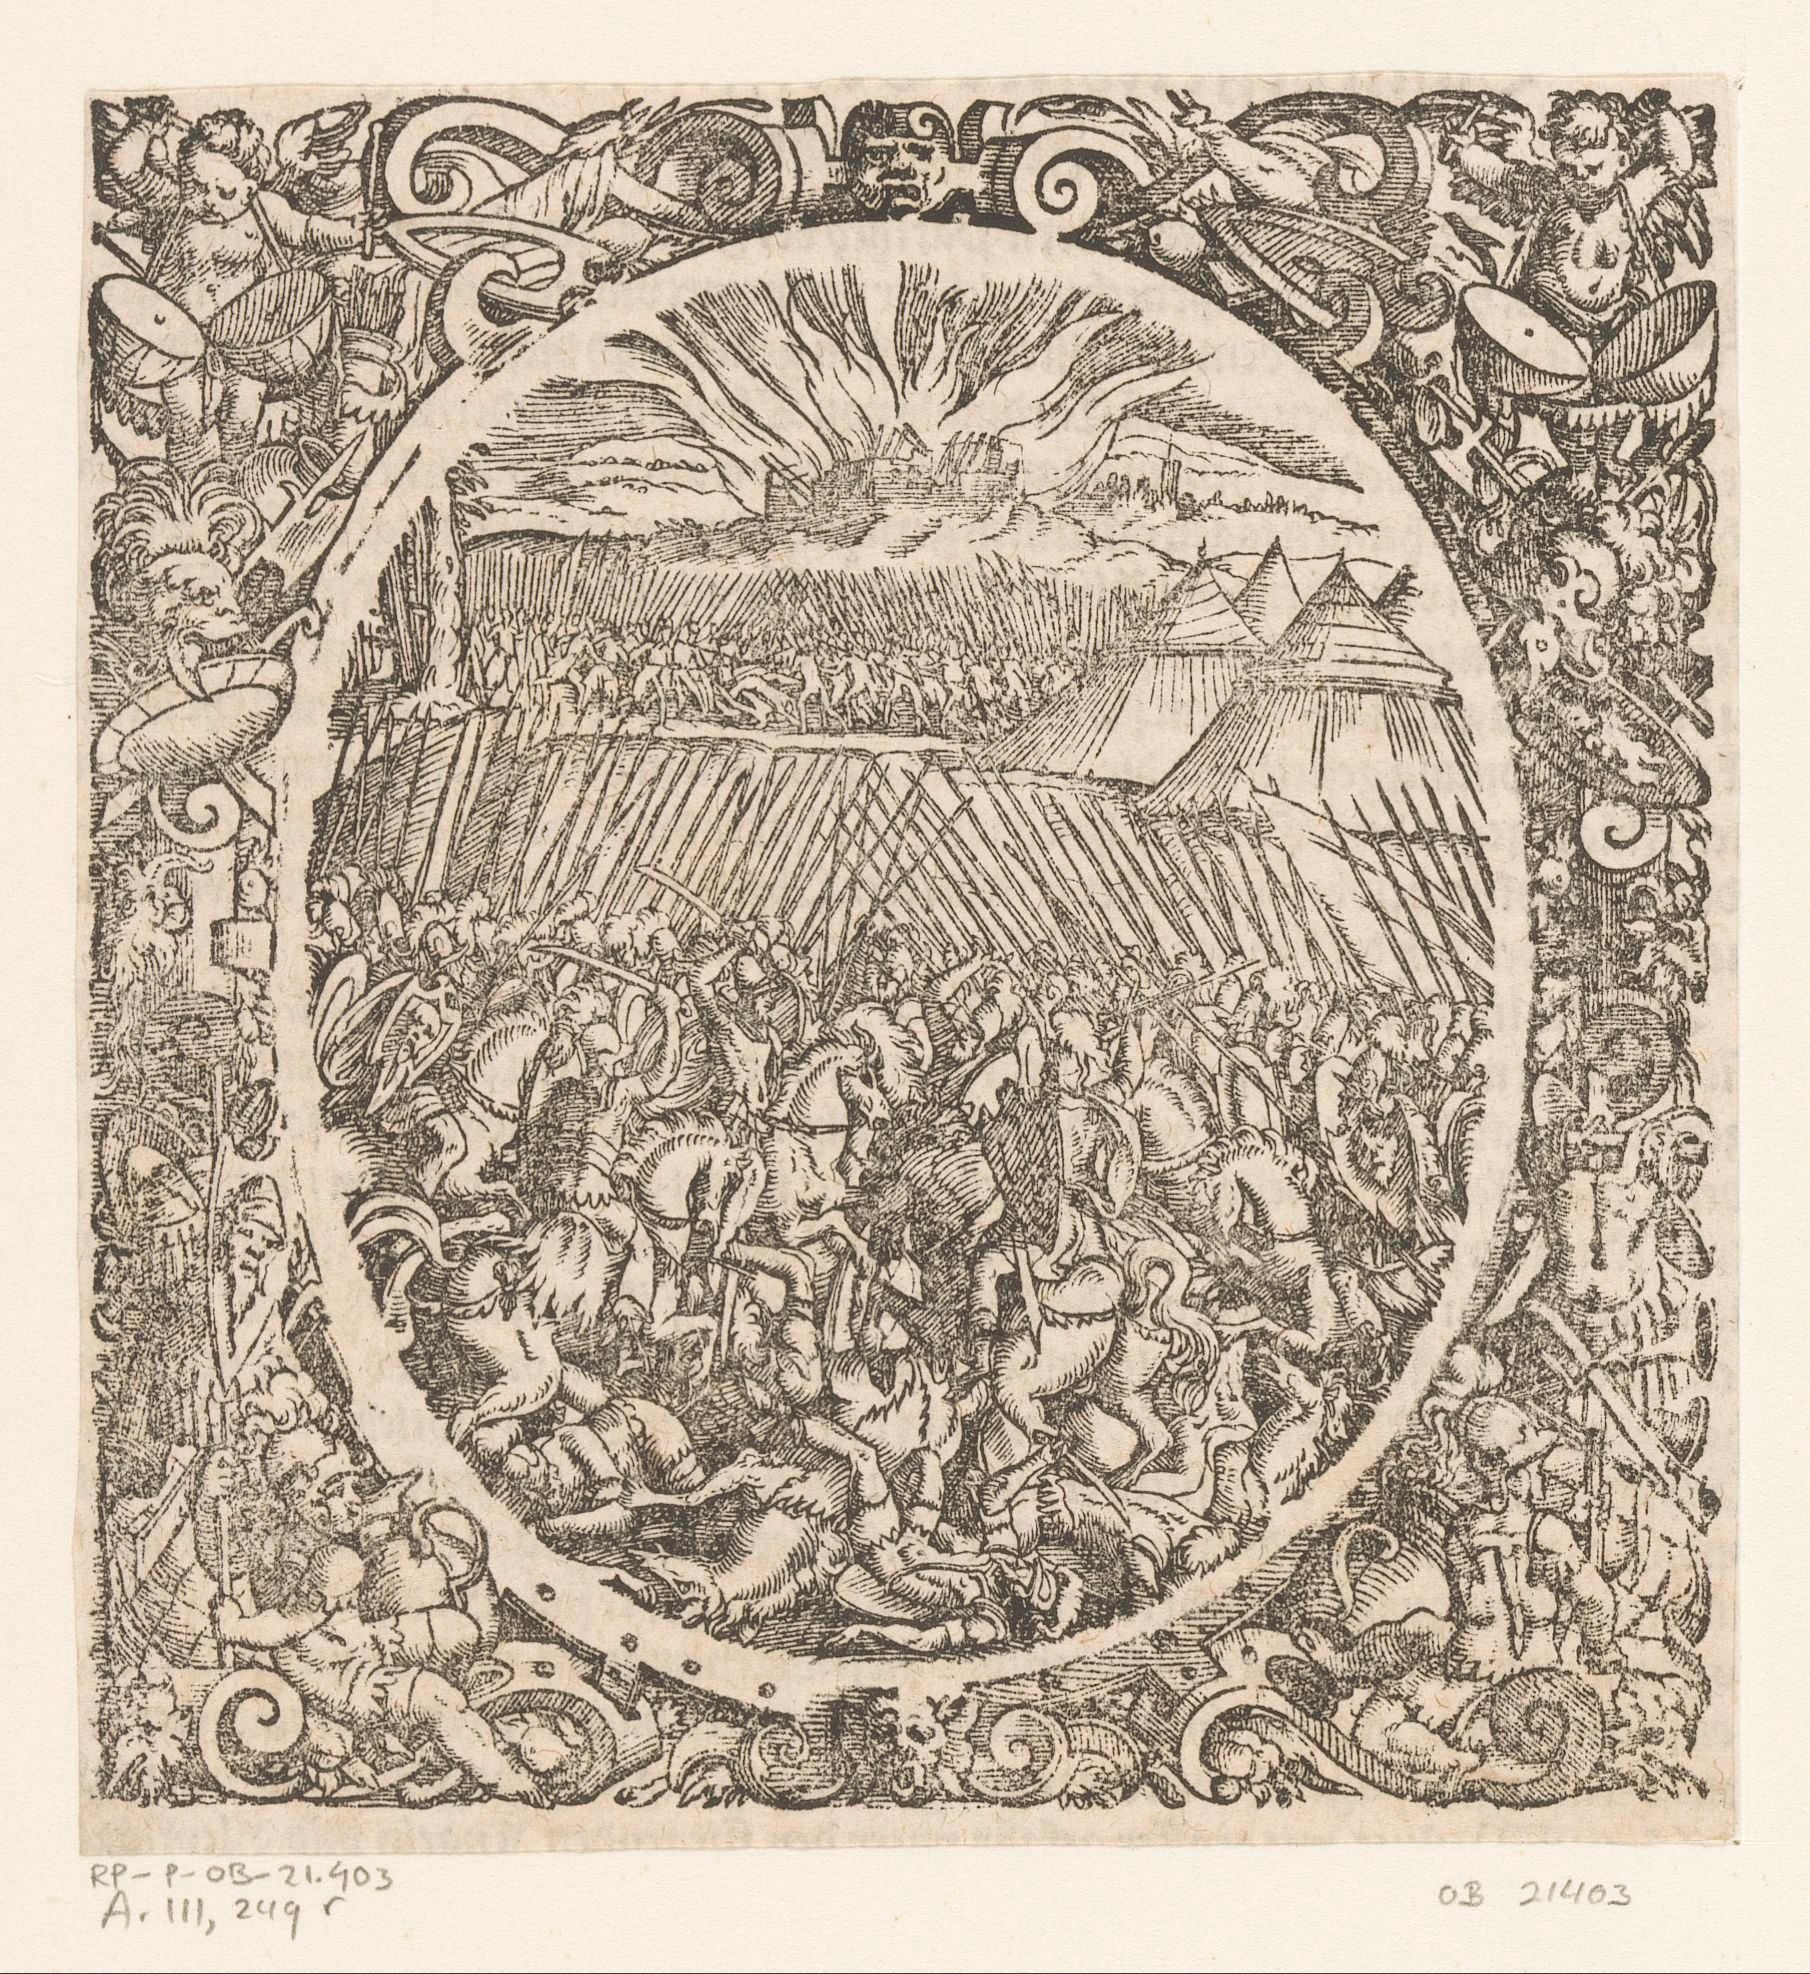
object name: print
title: Veldslag met op de achtergrond een brandende stad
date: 1573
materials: paper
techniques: woodcut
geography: nuremberg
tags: (military) camp with tents, battle, warfare; military affairs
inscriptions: collector's mark: Lugt 240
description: Zowel de voorstelling als de ornamentrand werd gebruikt voor verschillende edities van Leonhardt Fronspergers Kriegsbuch.